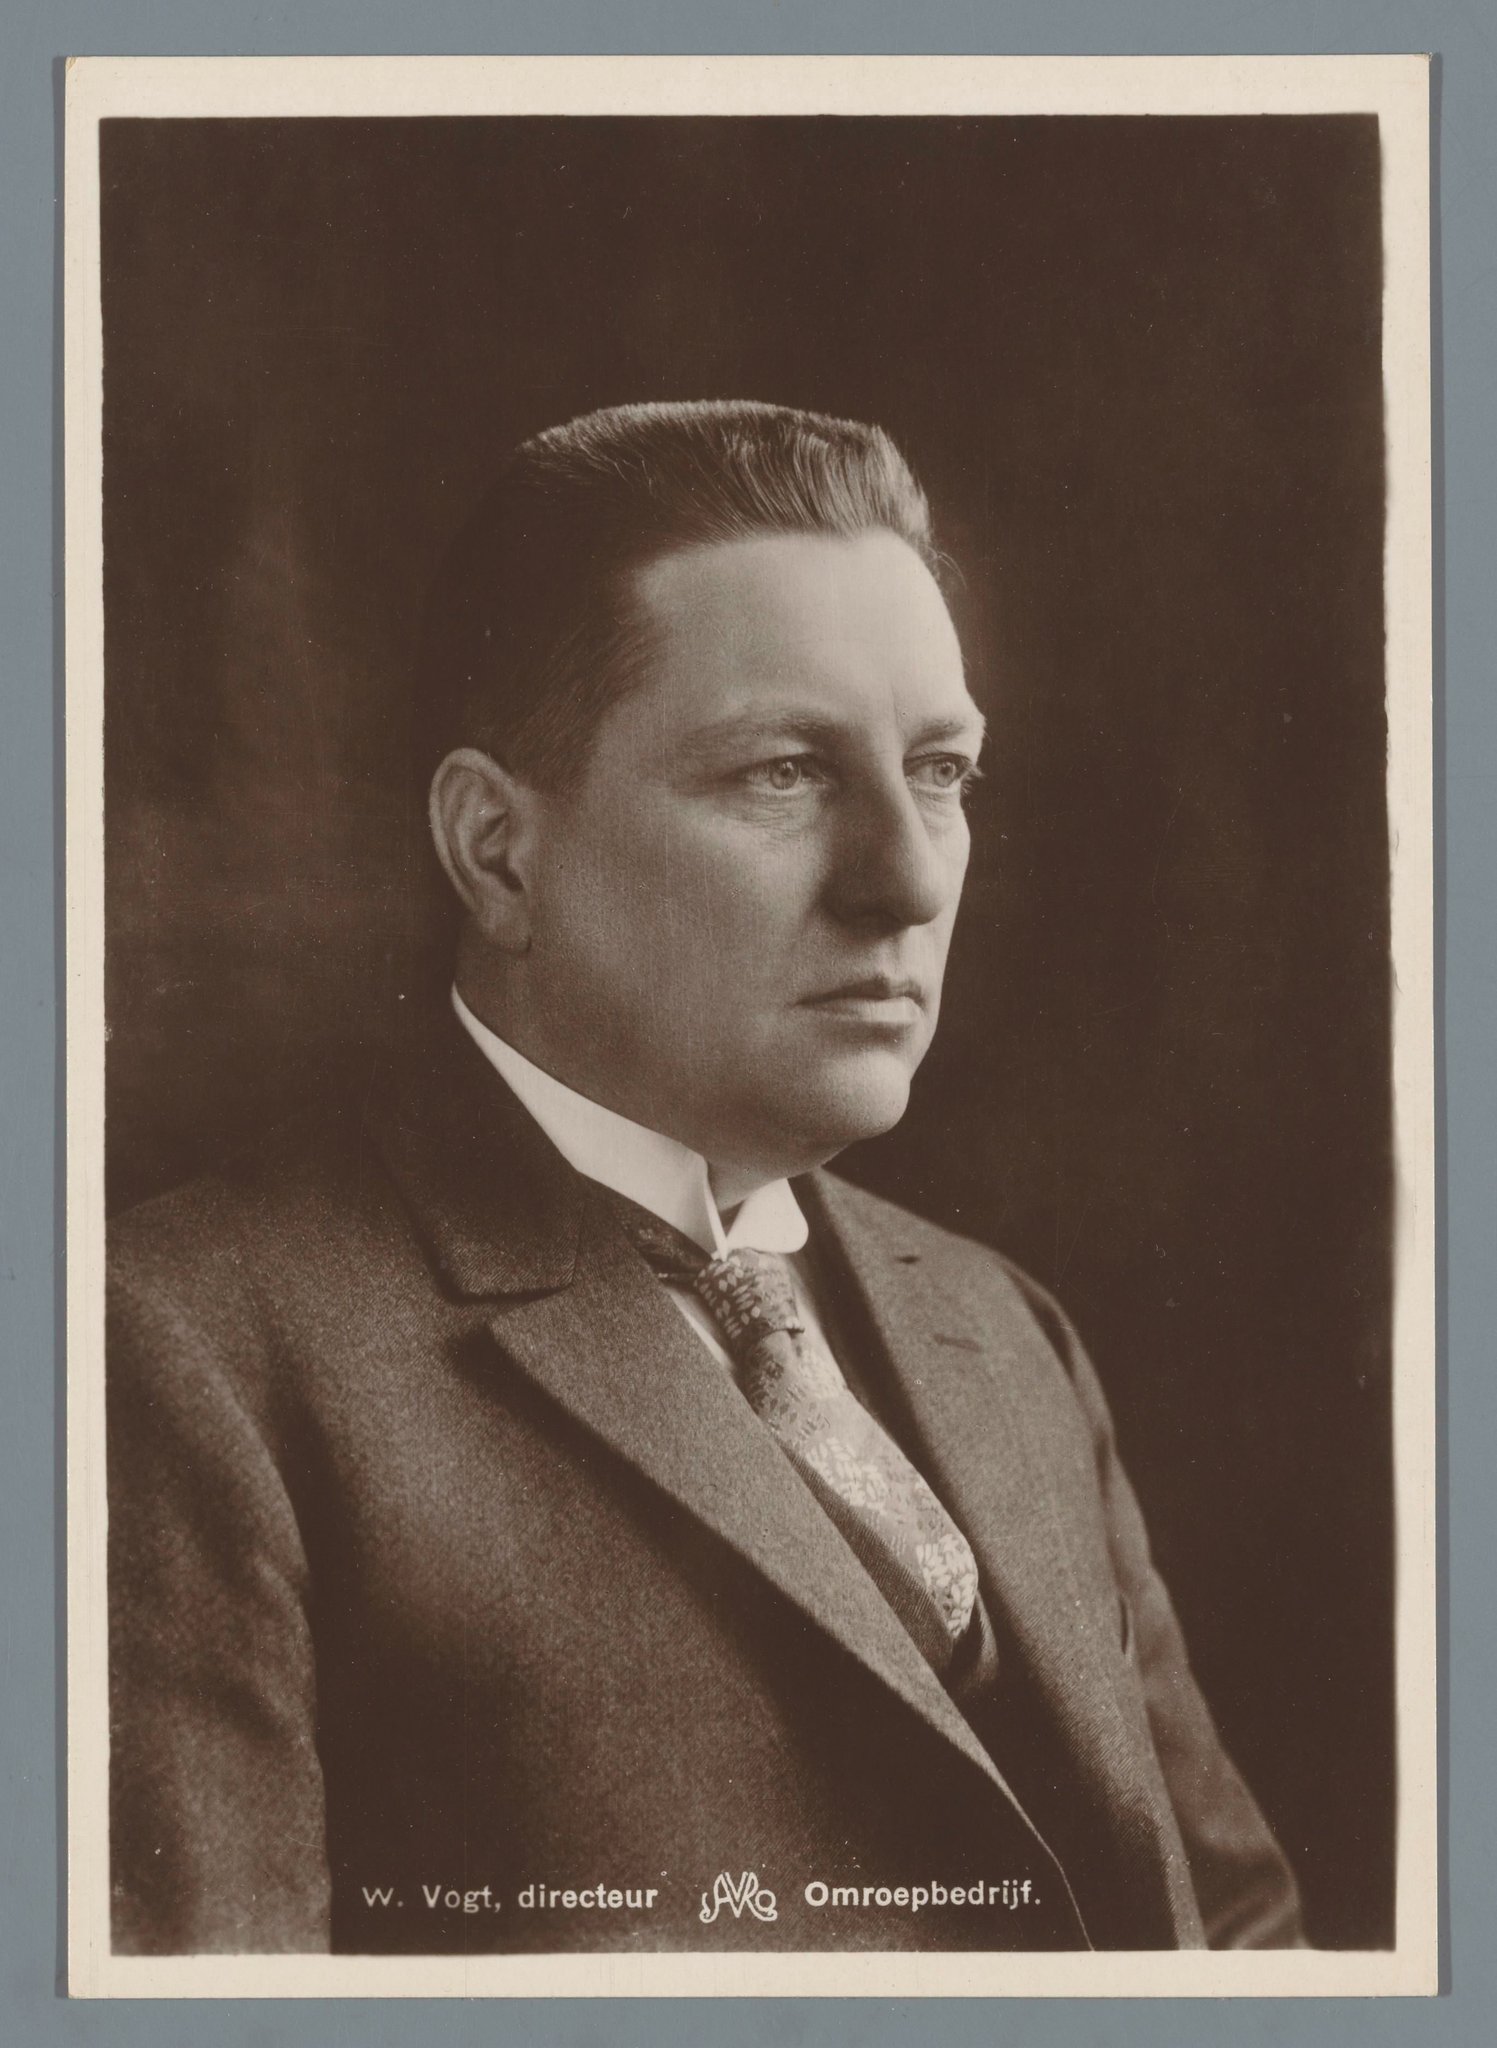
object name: photograph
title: Portret van Willem Vogt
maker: Anonymous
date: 1928-1945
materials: paper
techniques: gelatin silver print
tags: den helder, willem vogt, historical persons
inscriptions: number: ‘1’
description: Deze foto maakt deel uit van een omslag met tien foto's.